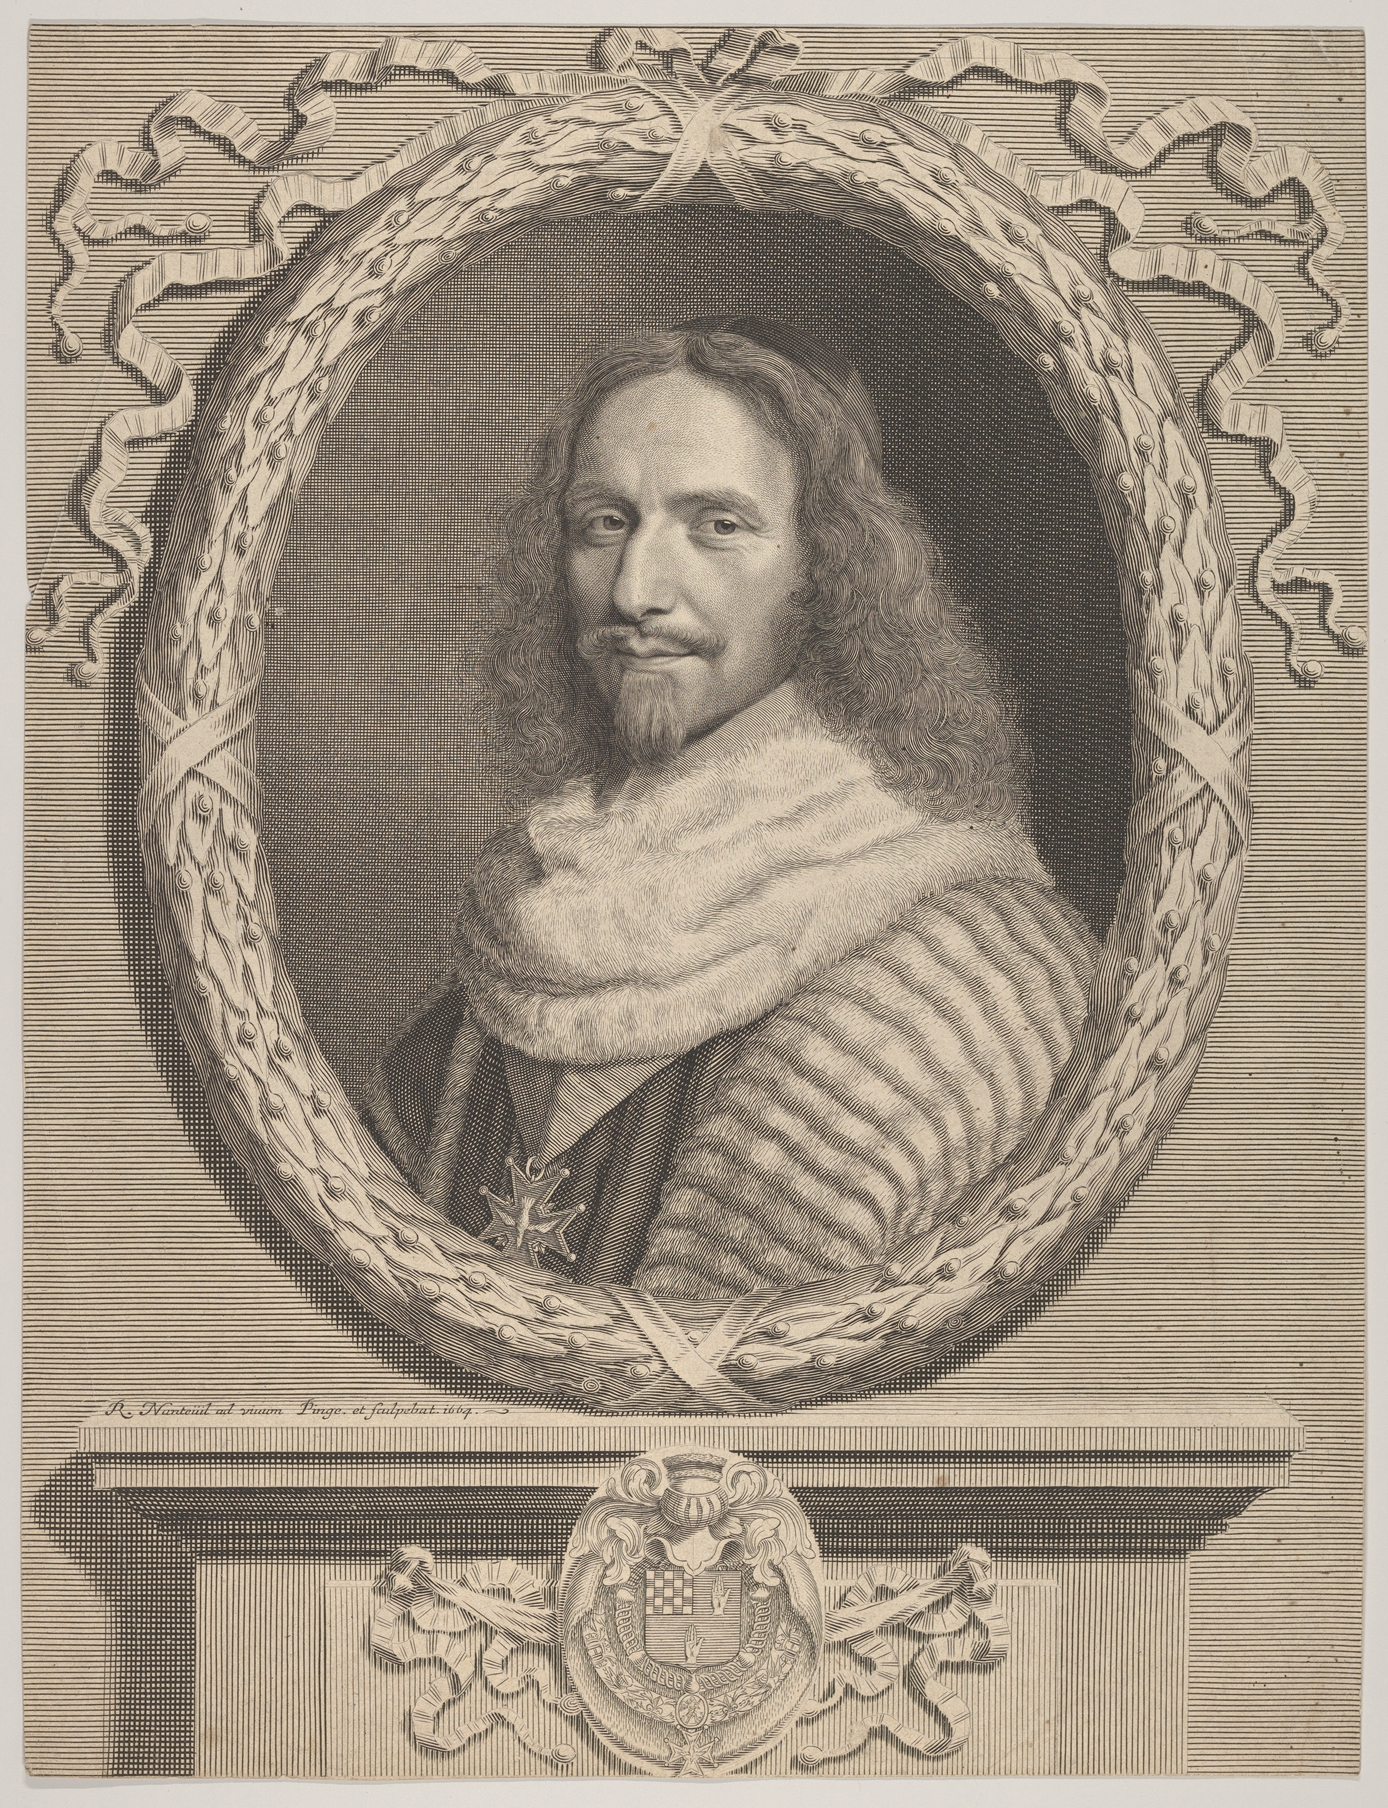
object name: print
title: Nicolas Potier de Novion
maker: robert nanteuil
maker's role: artist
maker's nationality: french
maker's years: 1623-1678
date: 1664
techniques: engraving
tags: men,portraits,coat of arms